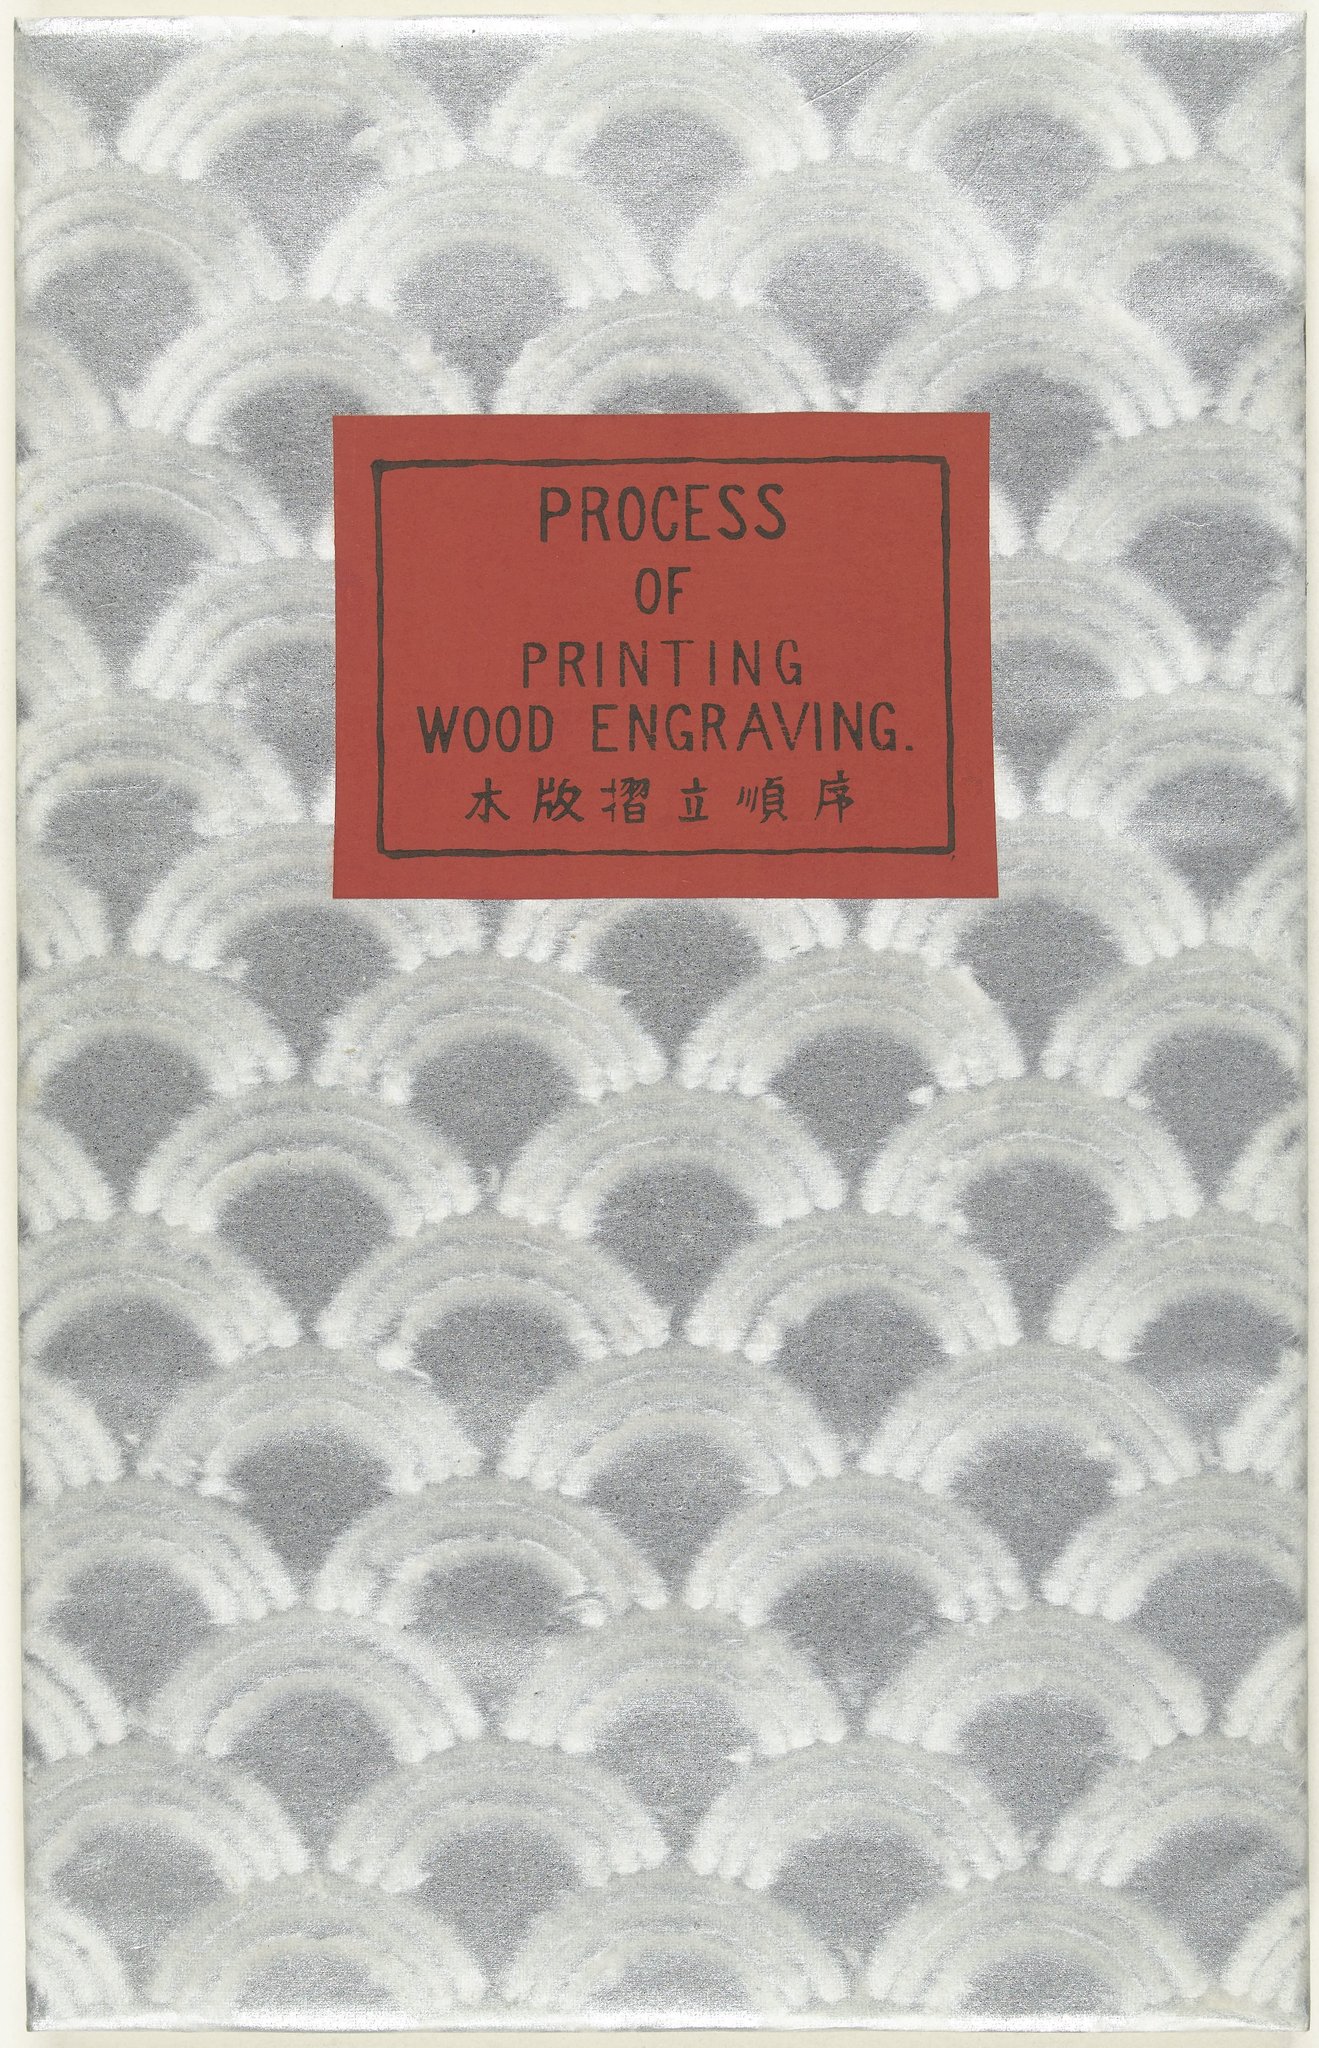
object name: prentrecueil, prentenalbum, prentalbum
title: Process of printing wood engraving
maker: takeuchi seihô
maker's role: print maker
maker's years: 1864-1942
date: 1937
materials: paper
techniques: woodcut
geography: japan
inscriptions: collector's mark: Lugt 2228